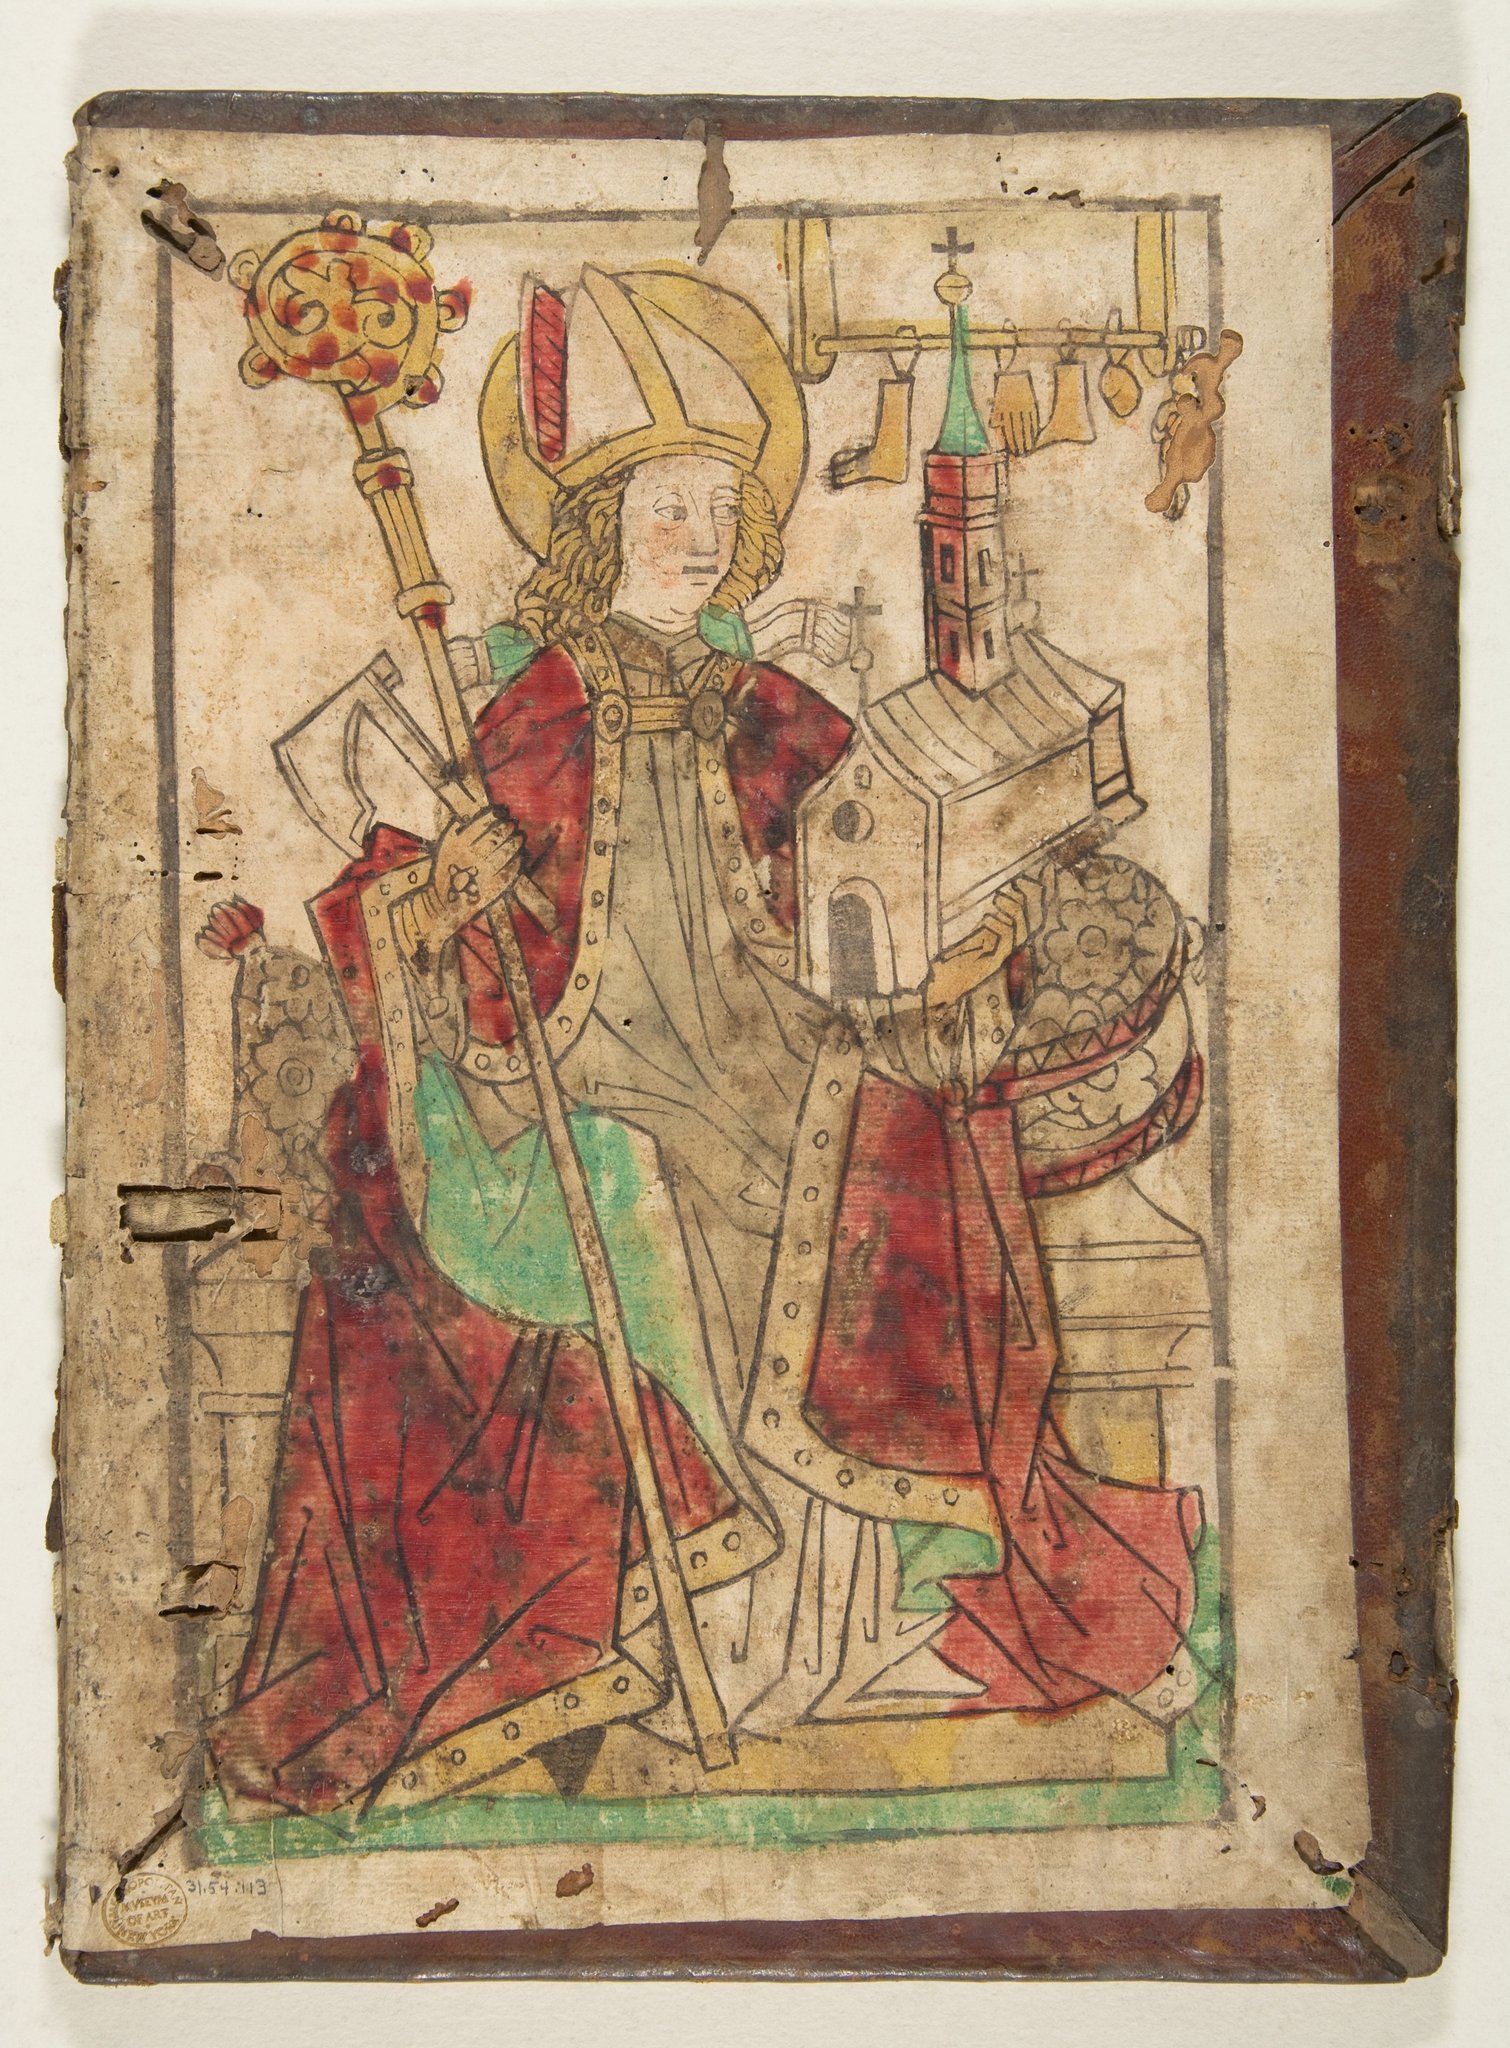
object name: print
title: Saint Wolfgang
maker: casper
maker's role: artist and publisher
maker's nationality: german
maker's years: 1400-1500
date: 1401-1500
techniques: hand coloring, woodcut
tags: croziers,saints